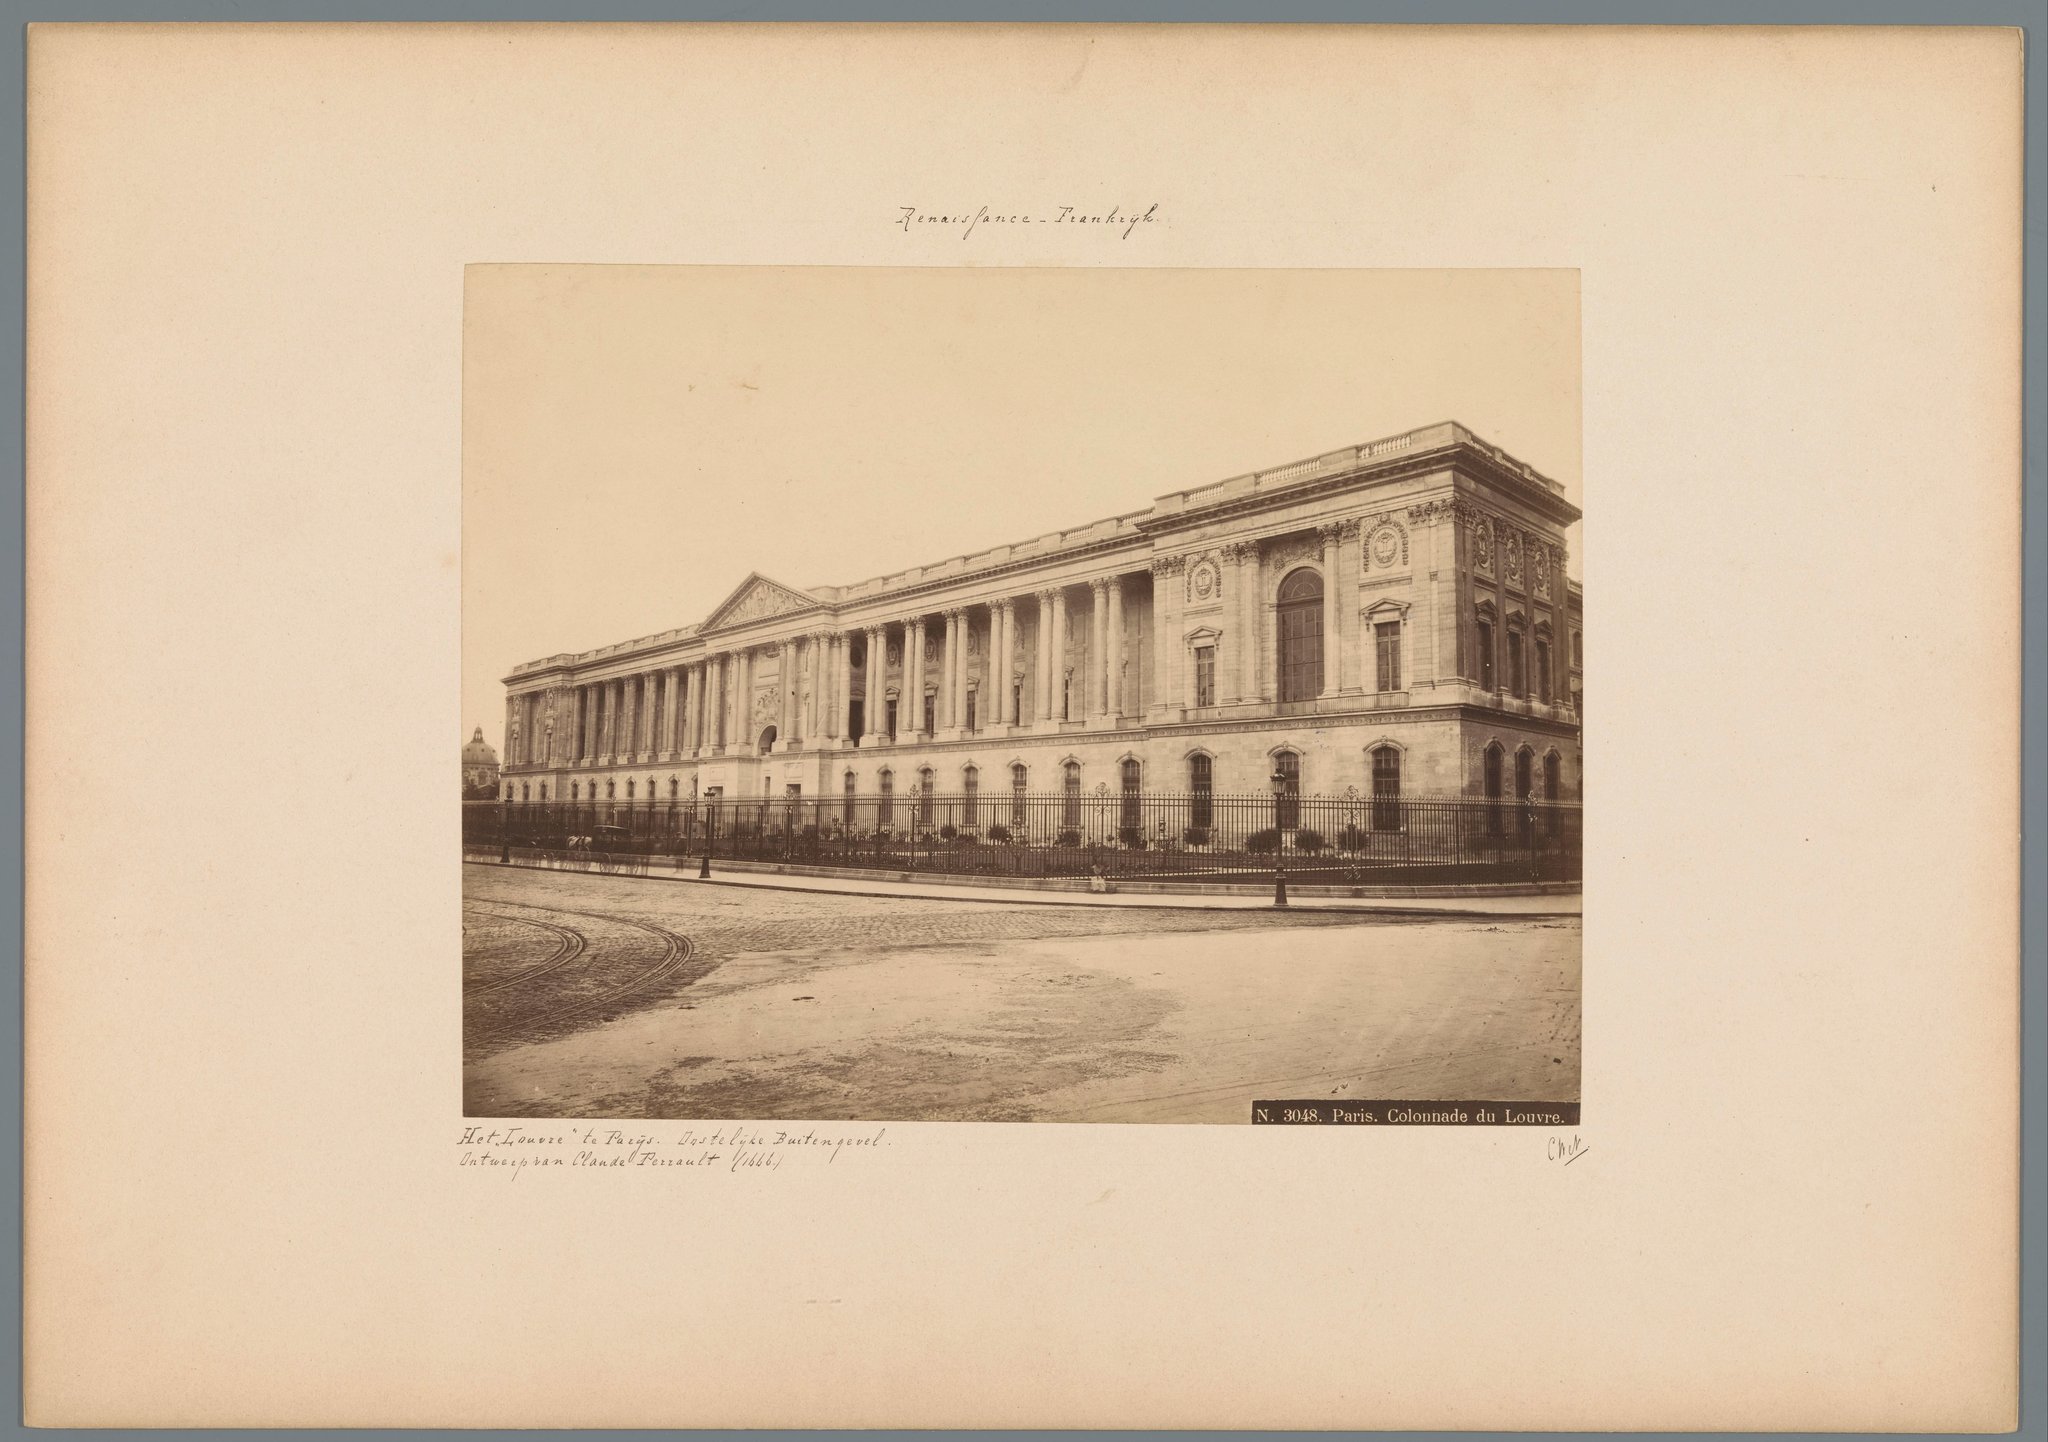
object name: photograph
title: Paris. Colonnade du Louvre.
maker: Anonymous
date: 1875-1900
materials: cardboard, photographic support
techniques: albumen print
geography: paris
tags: permanent exhibition, museum, exterior ~ representation of a building, façade (of house or building)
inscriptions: number: ‘N. 3048.’, inscription: ‘CWN.’, collector's mark: ‘KUNSTNIJVERHEIDSCHOOL QUELLINUS AMSTERDAM FRANS HALSSTRAAT 14.’, inscription: ‘Renaissance - Frankrijk. Het ,,Louvre'' te Parijs (...) Ontwerp van Claude Perrault (1666.)’, collector's mark: ‘INSTITUUT VOOR KUNST- NIJVERHEIDSONDERWIJS GABRIËL METSUSTRAAT No. 16. AMSTERDAM’